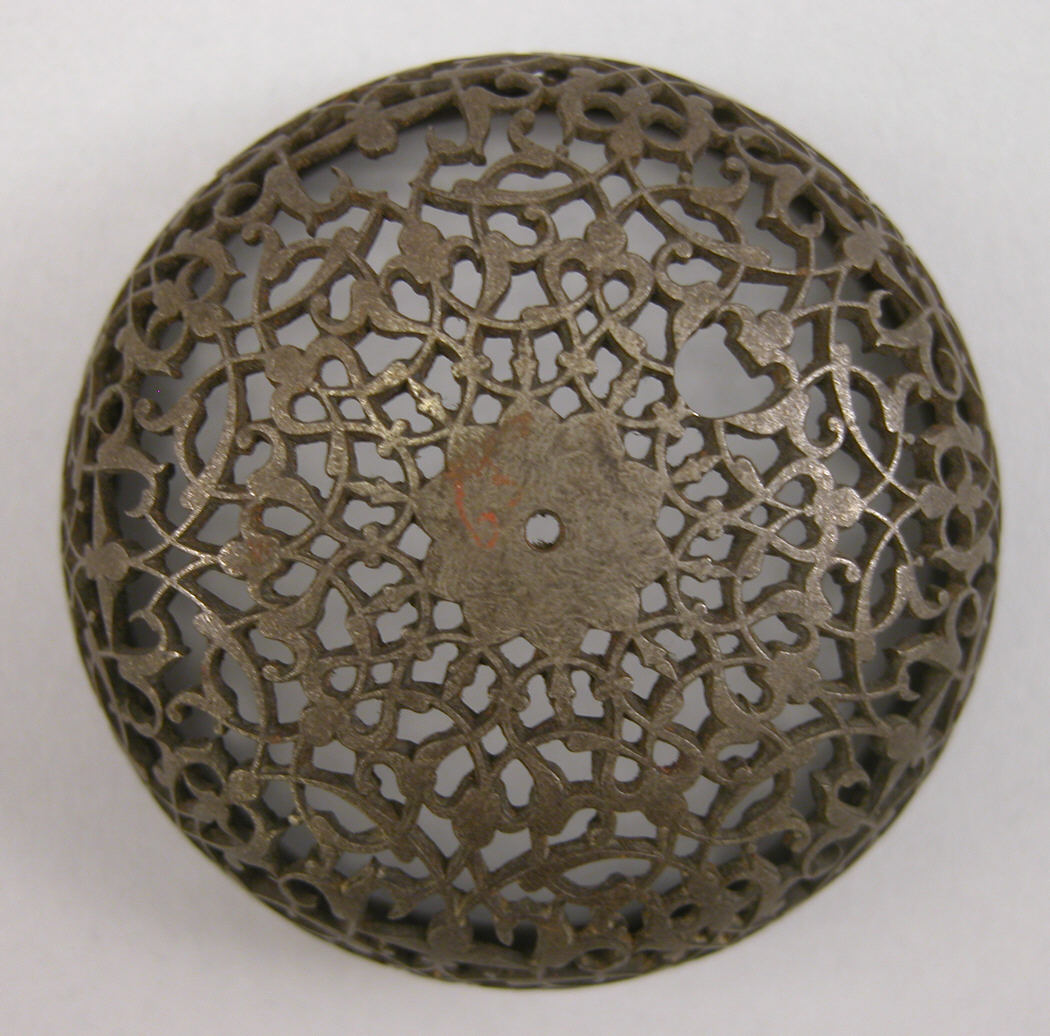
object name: lid or bos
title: Ornamental Boss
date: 1501-1600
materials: steel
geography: iran